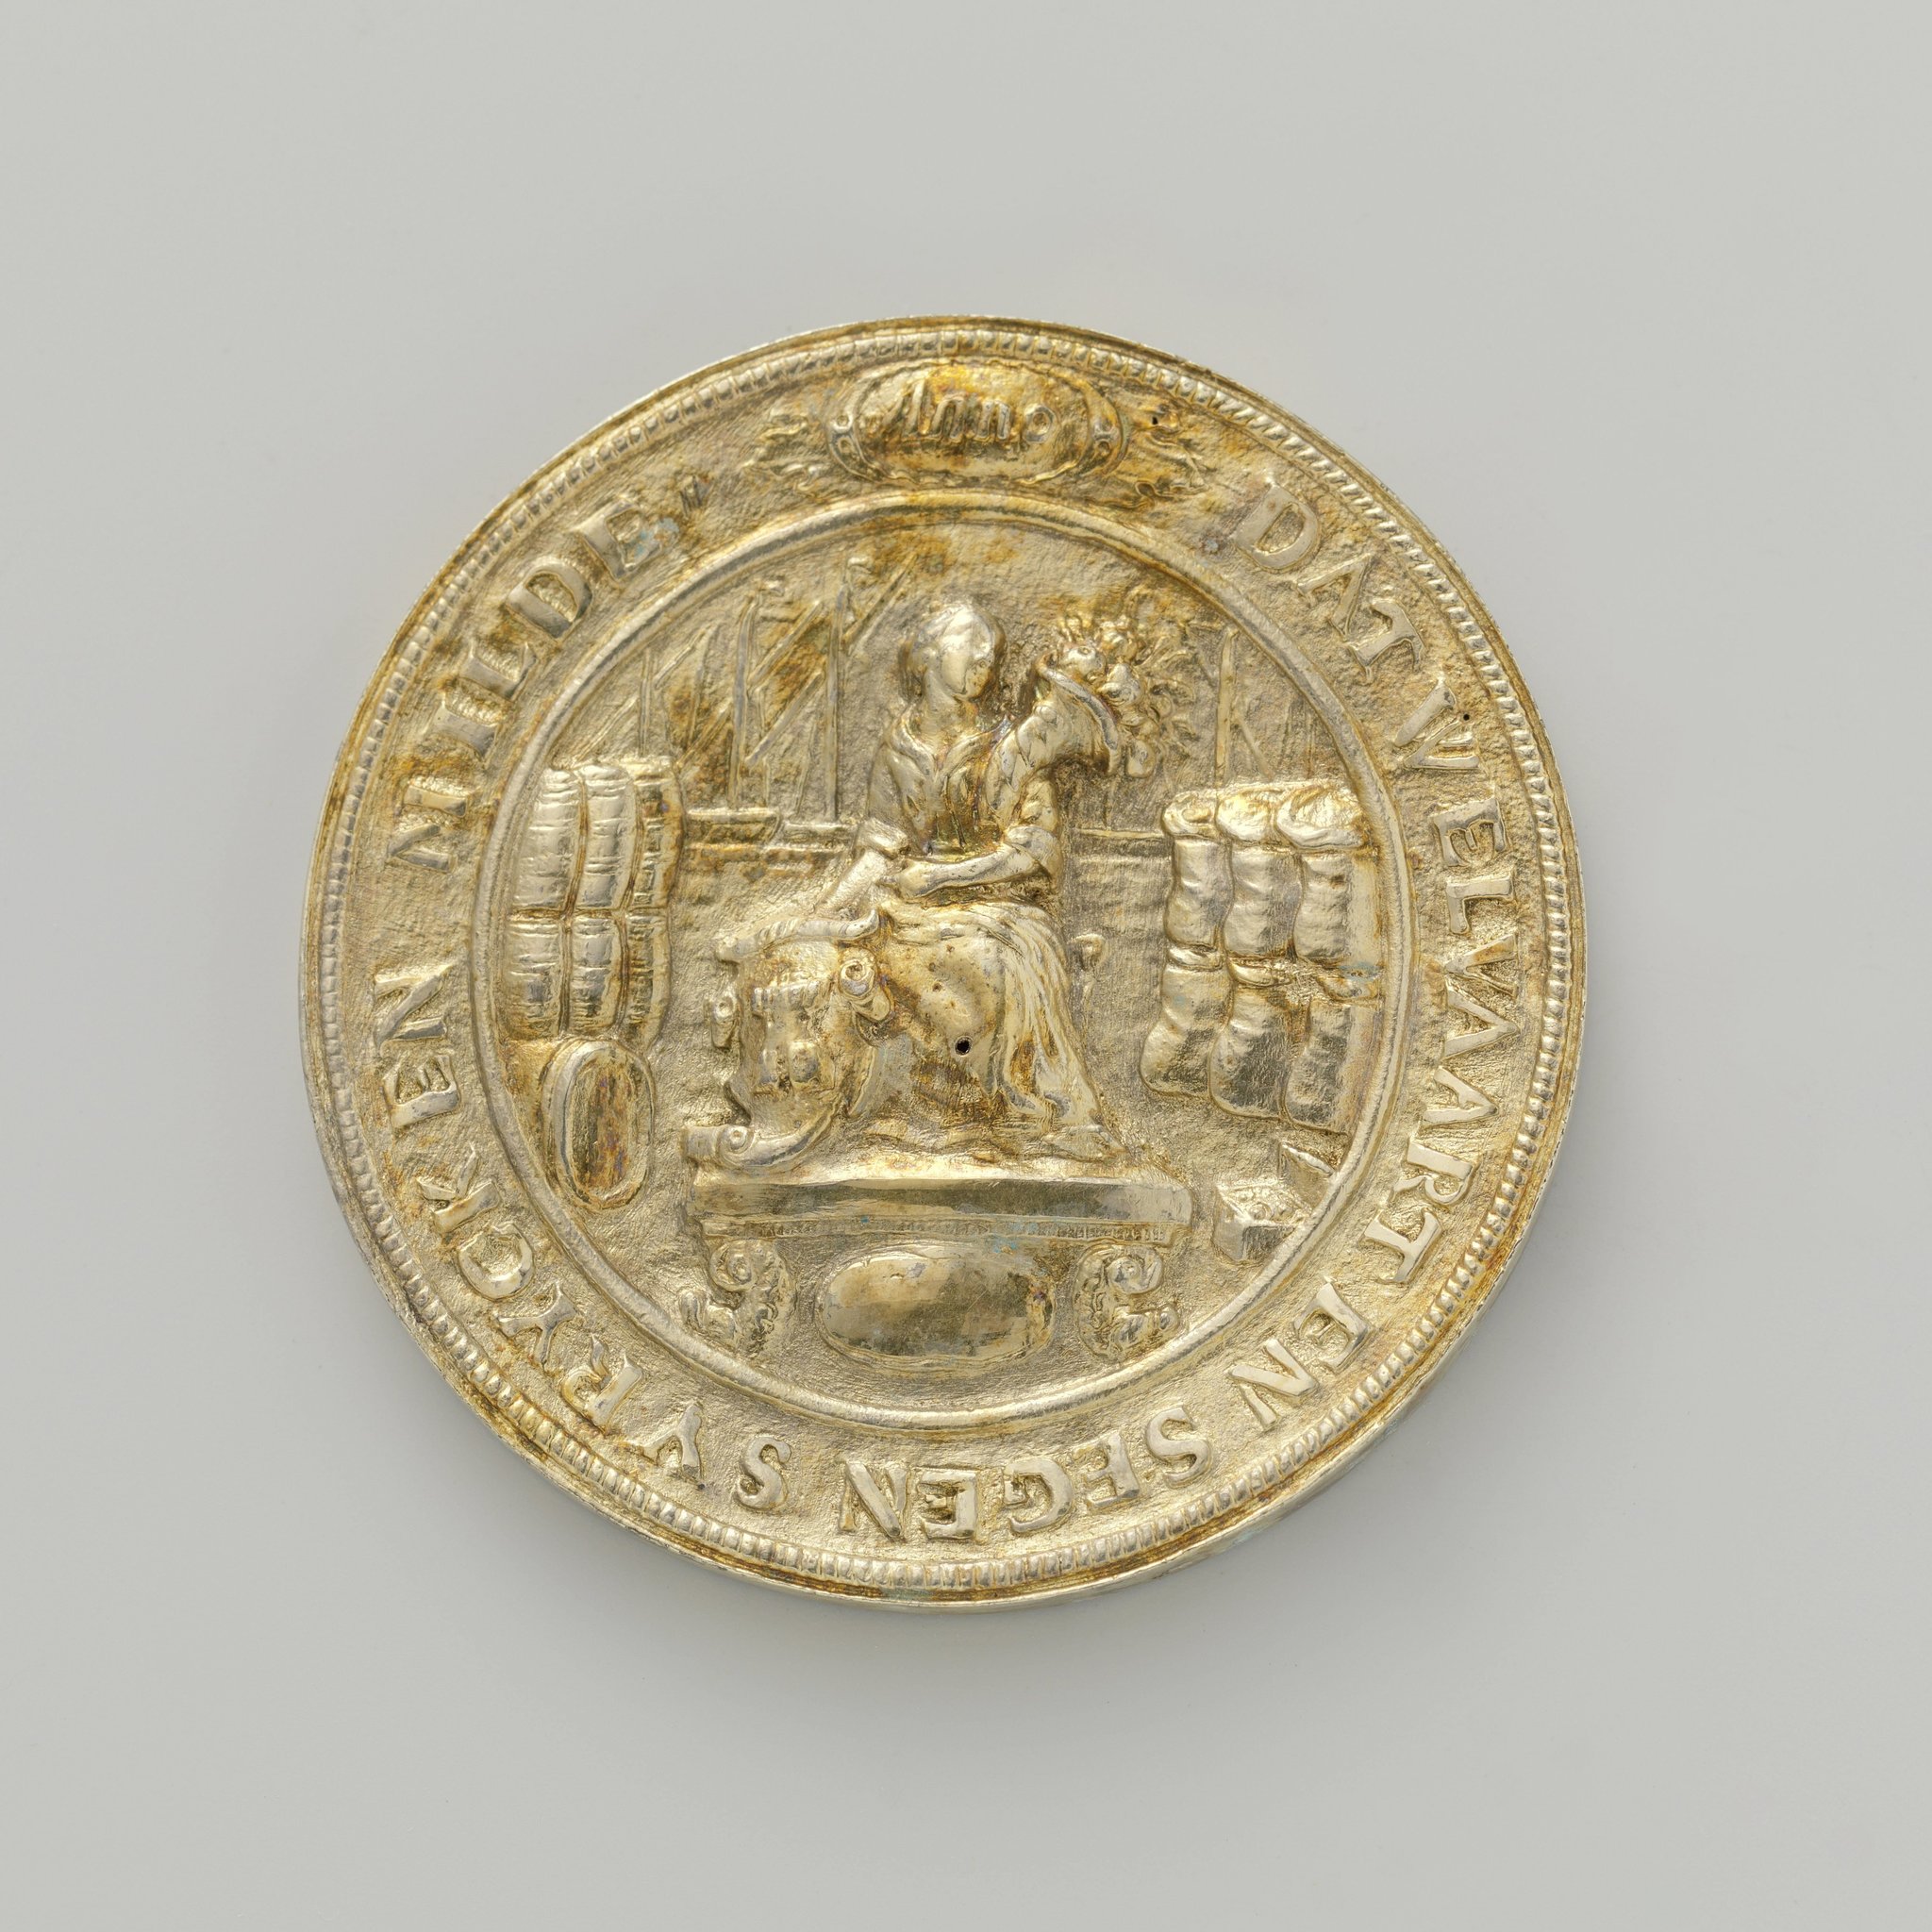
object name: medal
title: Victuallers’ Guild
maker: Anonymous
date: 1698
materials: silver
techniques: casting, gilding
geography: middelburg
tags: middelburg